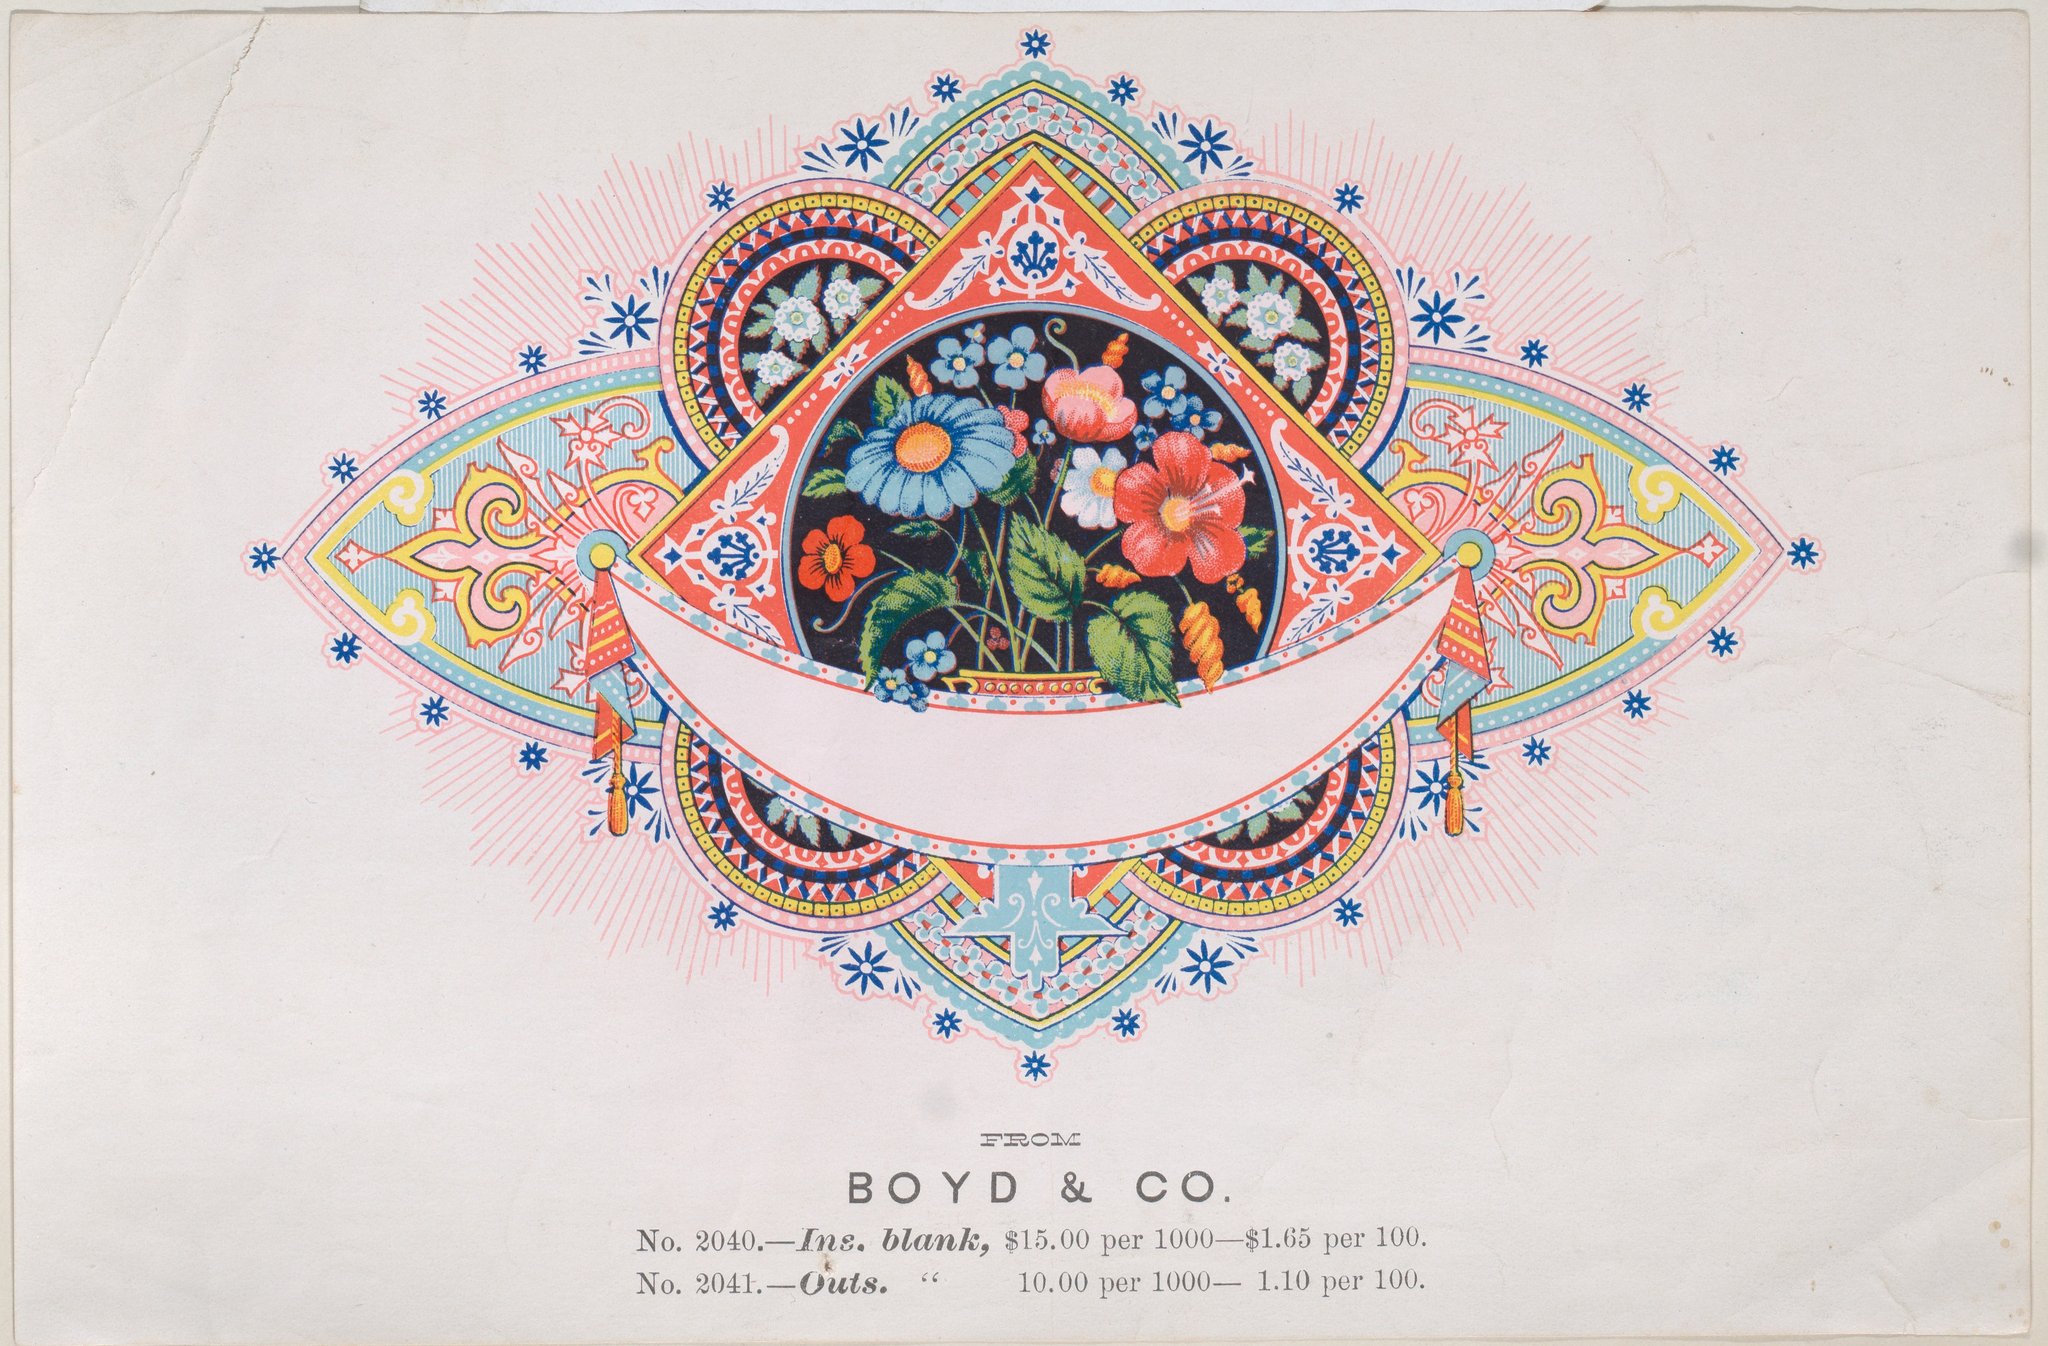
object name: print, trade card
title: Trade Card for Boyd & Co., Printer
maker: anonymous, american, 19th century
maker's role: artist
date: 1801-1900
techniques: lithography